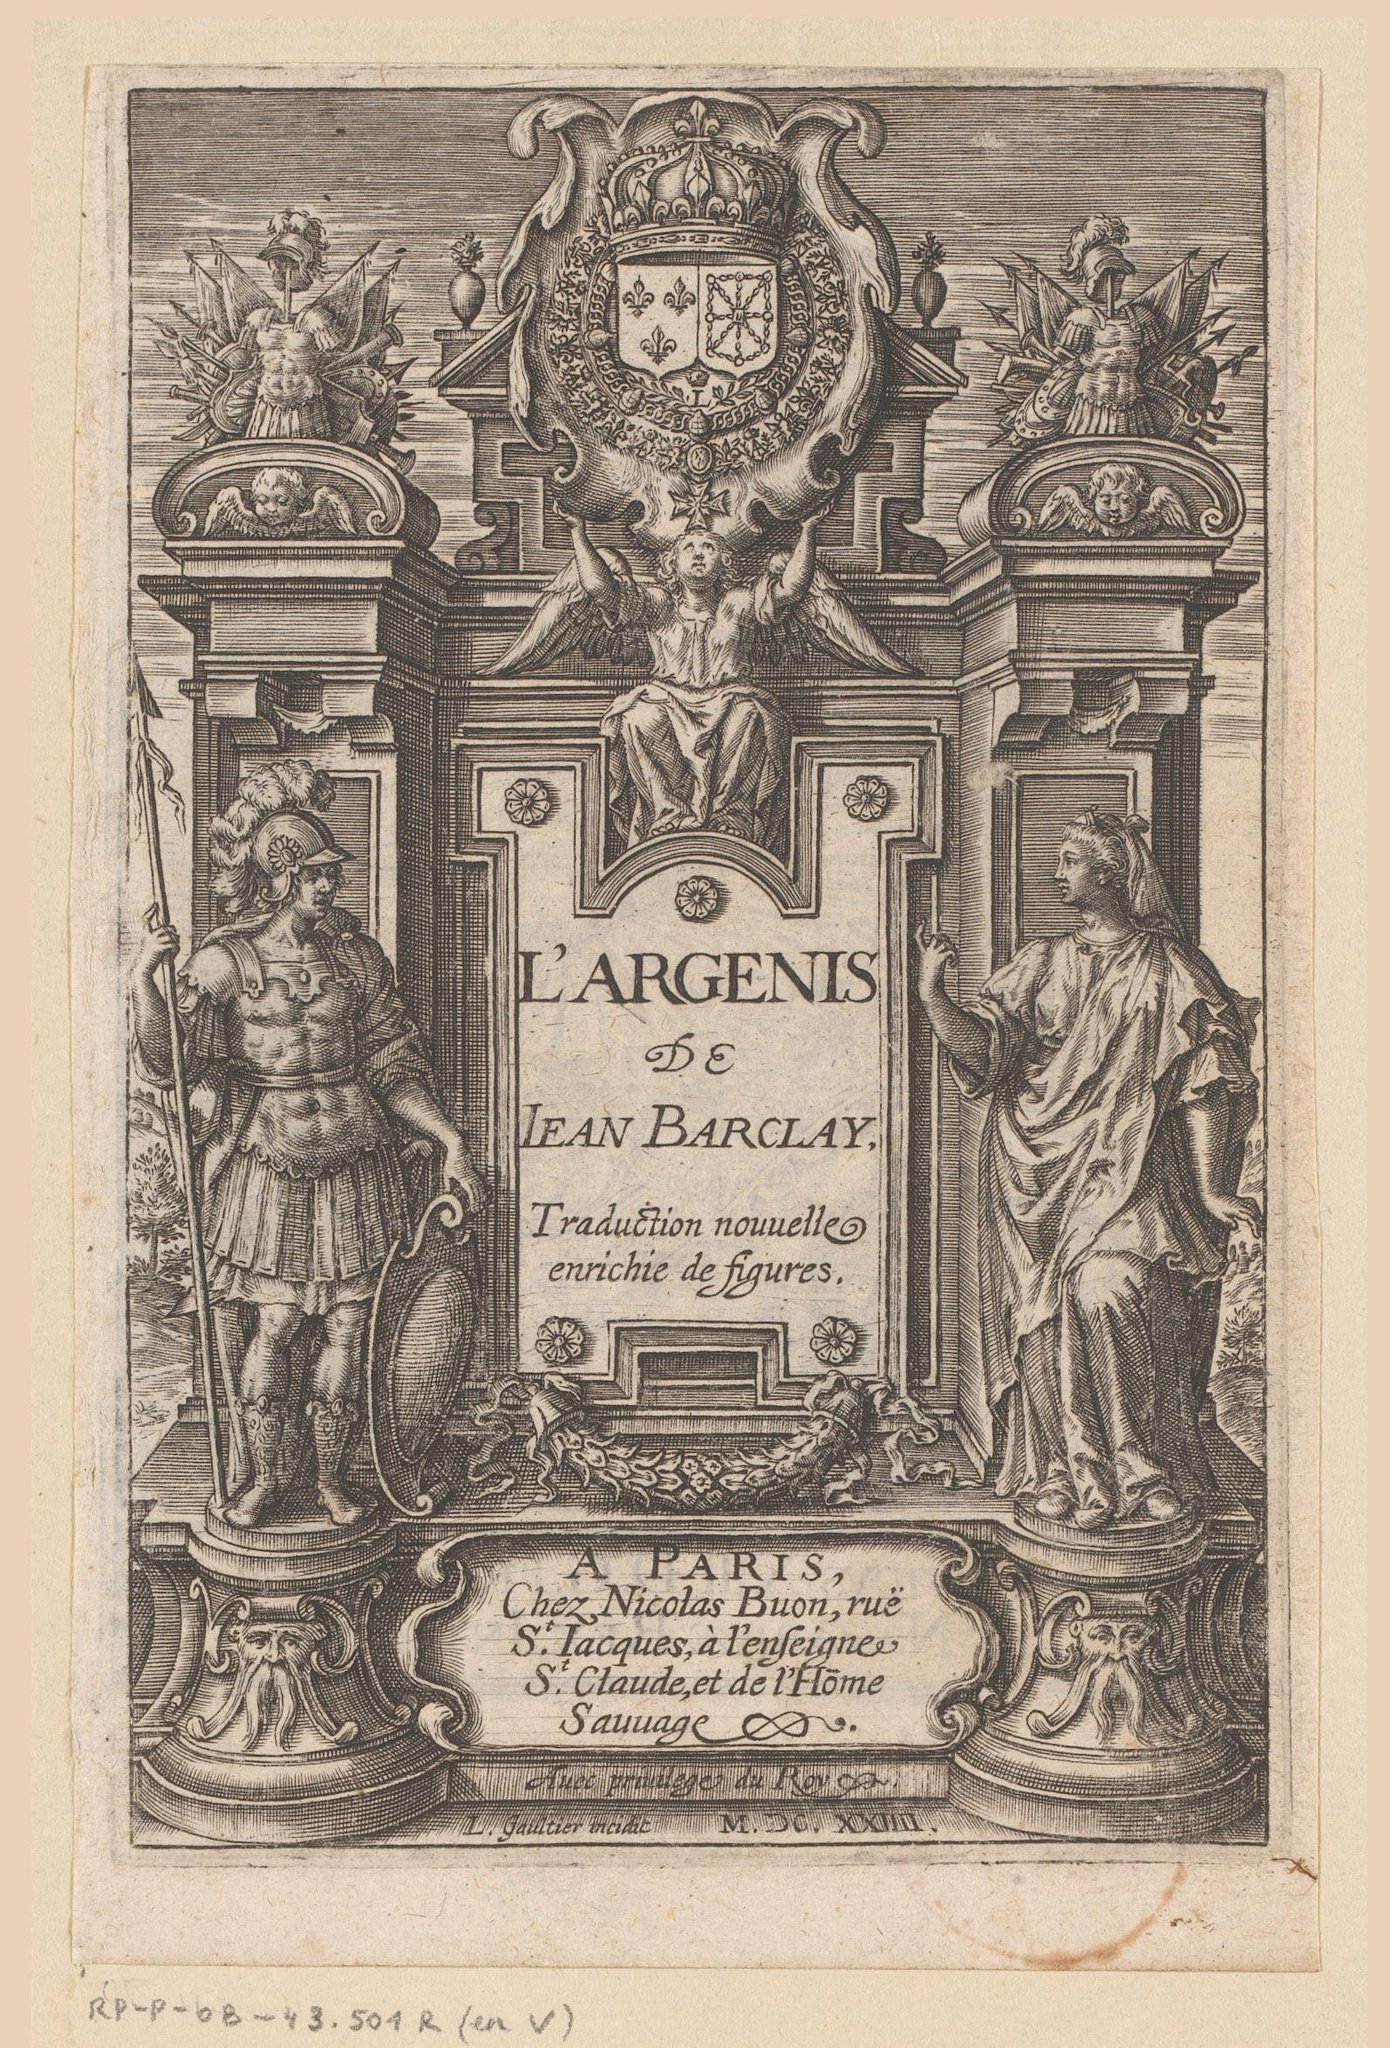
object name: titelblad, titelpagina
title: Wapenschild in monumentale lijst met allegorische figuren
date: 1624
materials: paper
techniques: engraving, etching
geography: france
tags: symbolic representations, allegories and emblems ~ the monumental arts, armorial bearing, heraldry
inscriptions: collector's mark: Lugt 240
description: Titelpagina voor: Barclay, Jean. L'Argénis. Parijs: Claude Griset, 1624.